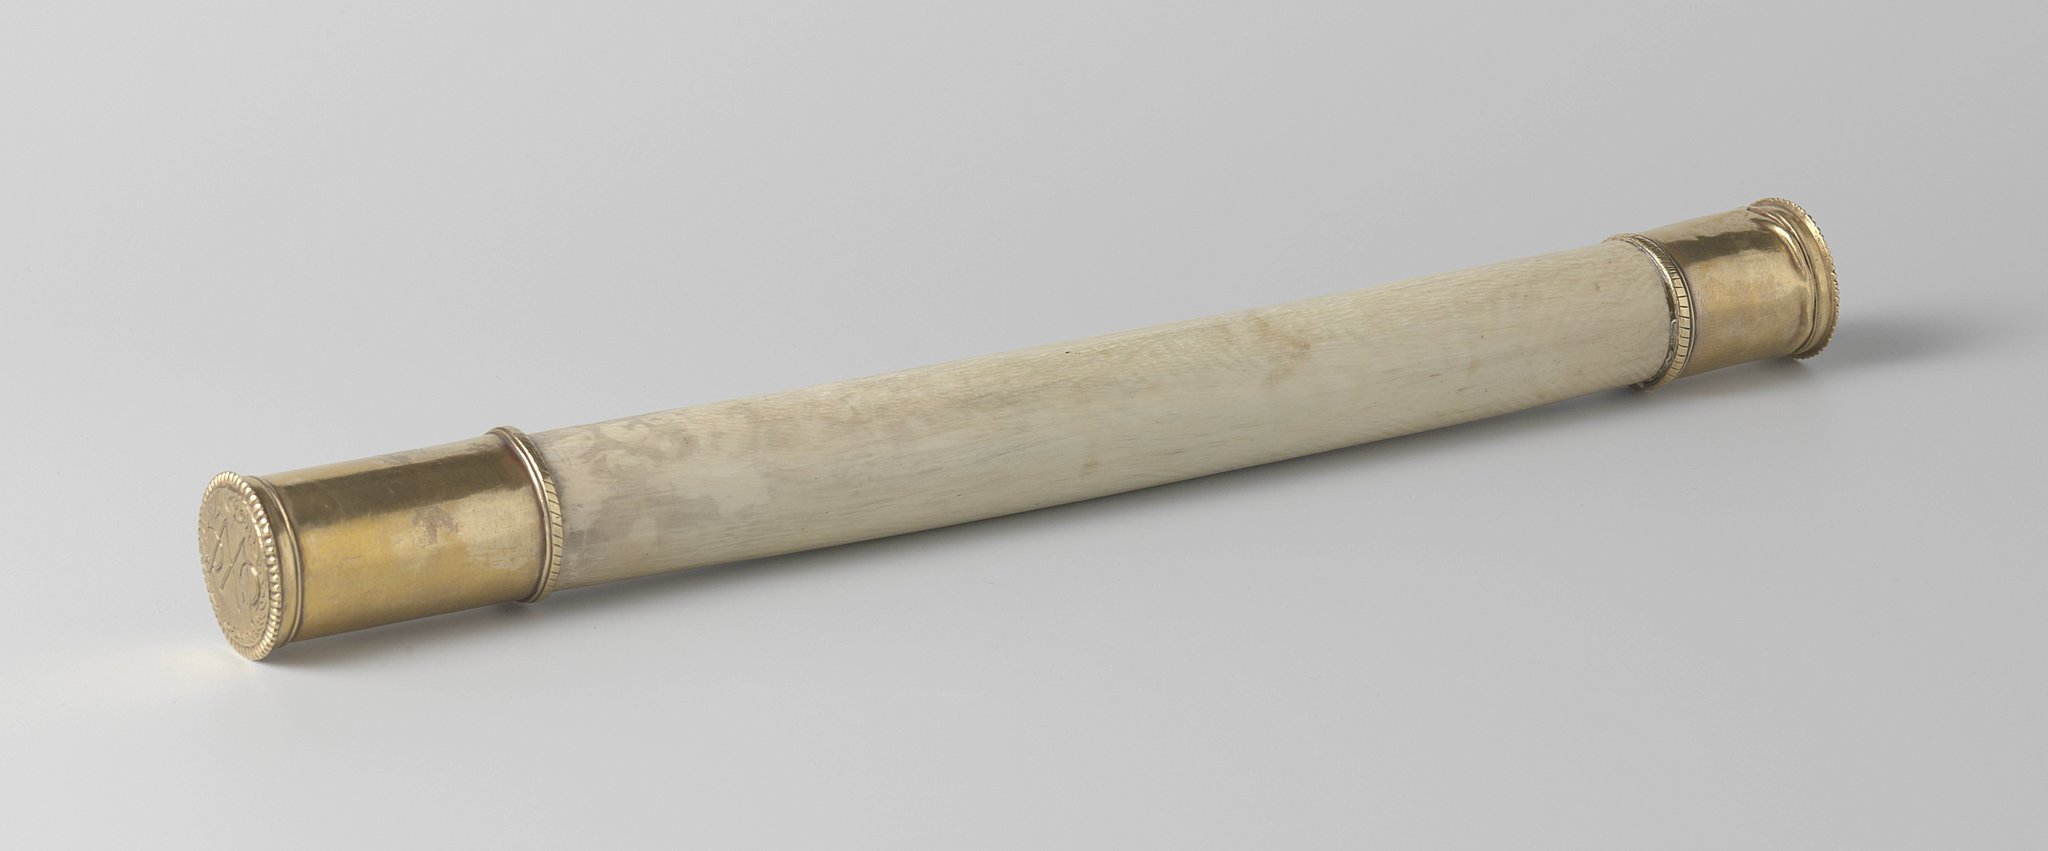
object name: commandostaf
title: Commander’s baton of the Dutch Governor of the Gold Coast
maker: Anonymous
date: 1600-1699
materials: gold, ivory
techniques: cutting, engraving, forging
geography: west africa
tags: guinea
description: The running of the Dutch West India Company in West Africa was in the hands of the director-general in Fort Elmina. The commander’s baton lay before him on the table when he assembled his Kleine Raad (Small Council). The gold mounts on the ivory baton bear the monogram, GWC, of the Chartered West India Company.